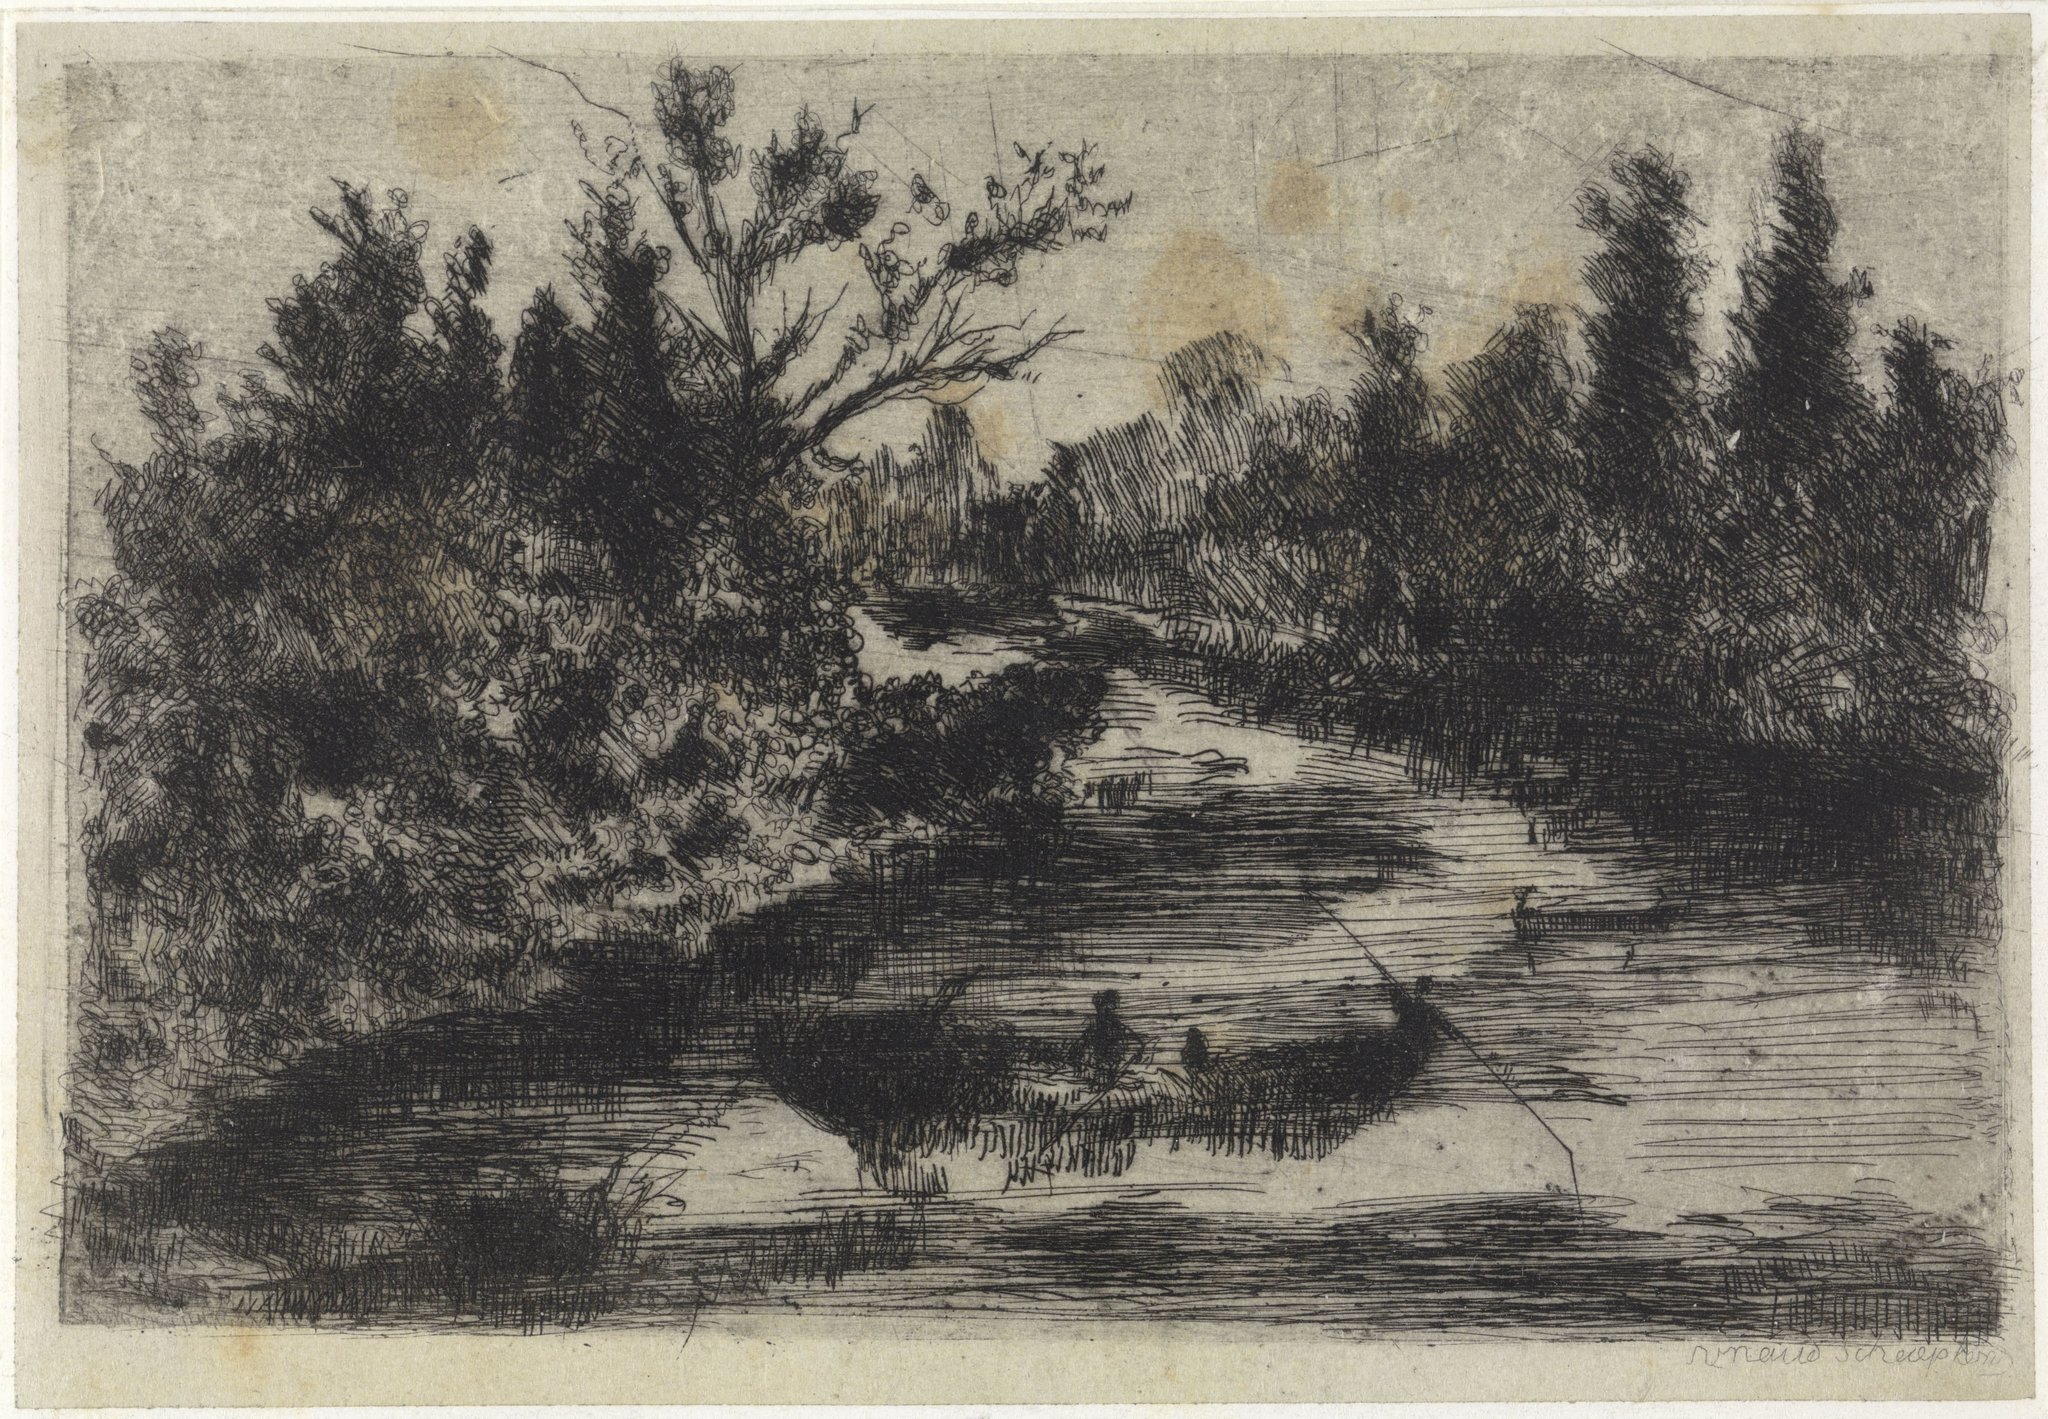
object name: print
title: Kanaal met boot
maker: arnoud schaepkens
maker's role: print maker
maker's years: 1816-1904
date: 1831-1904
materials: paper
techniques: etching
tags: canal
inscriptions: collector's mark: Lugt 2228